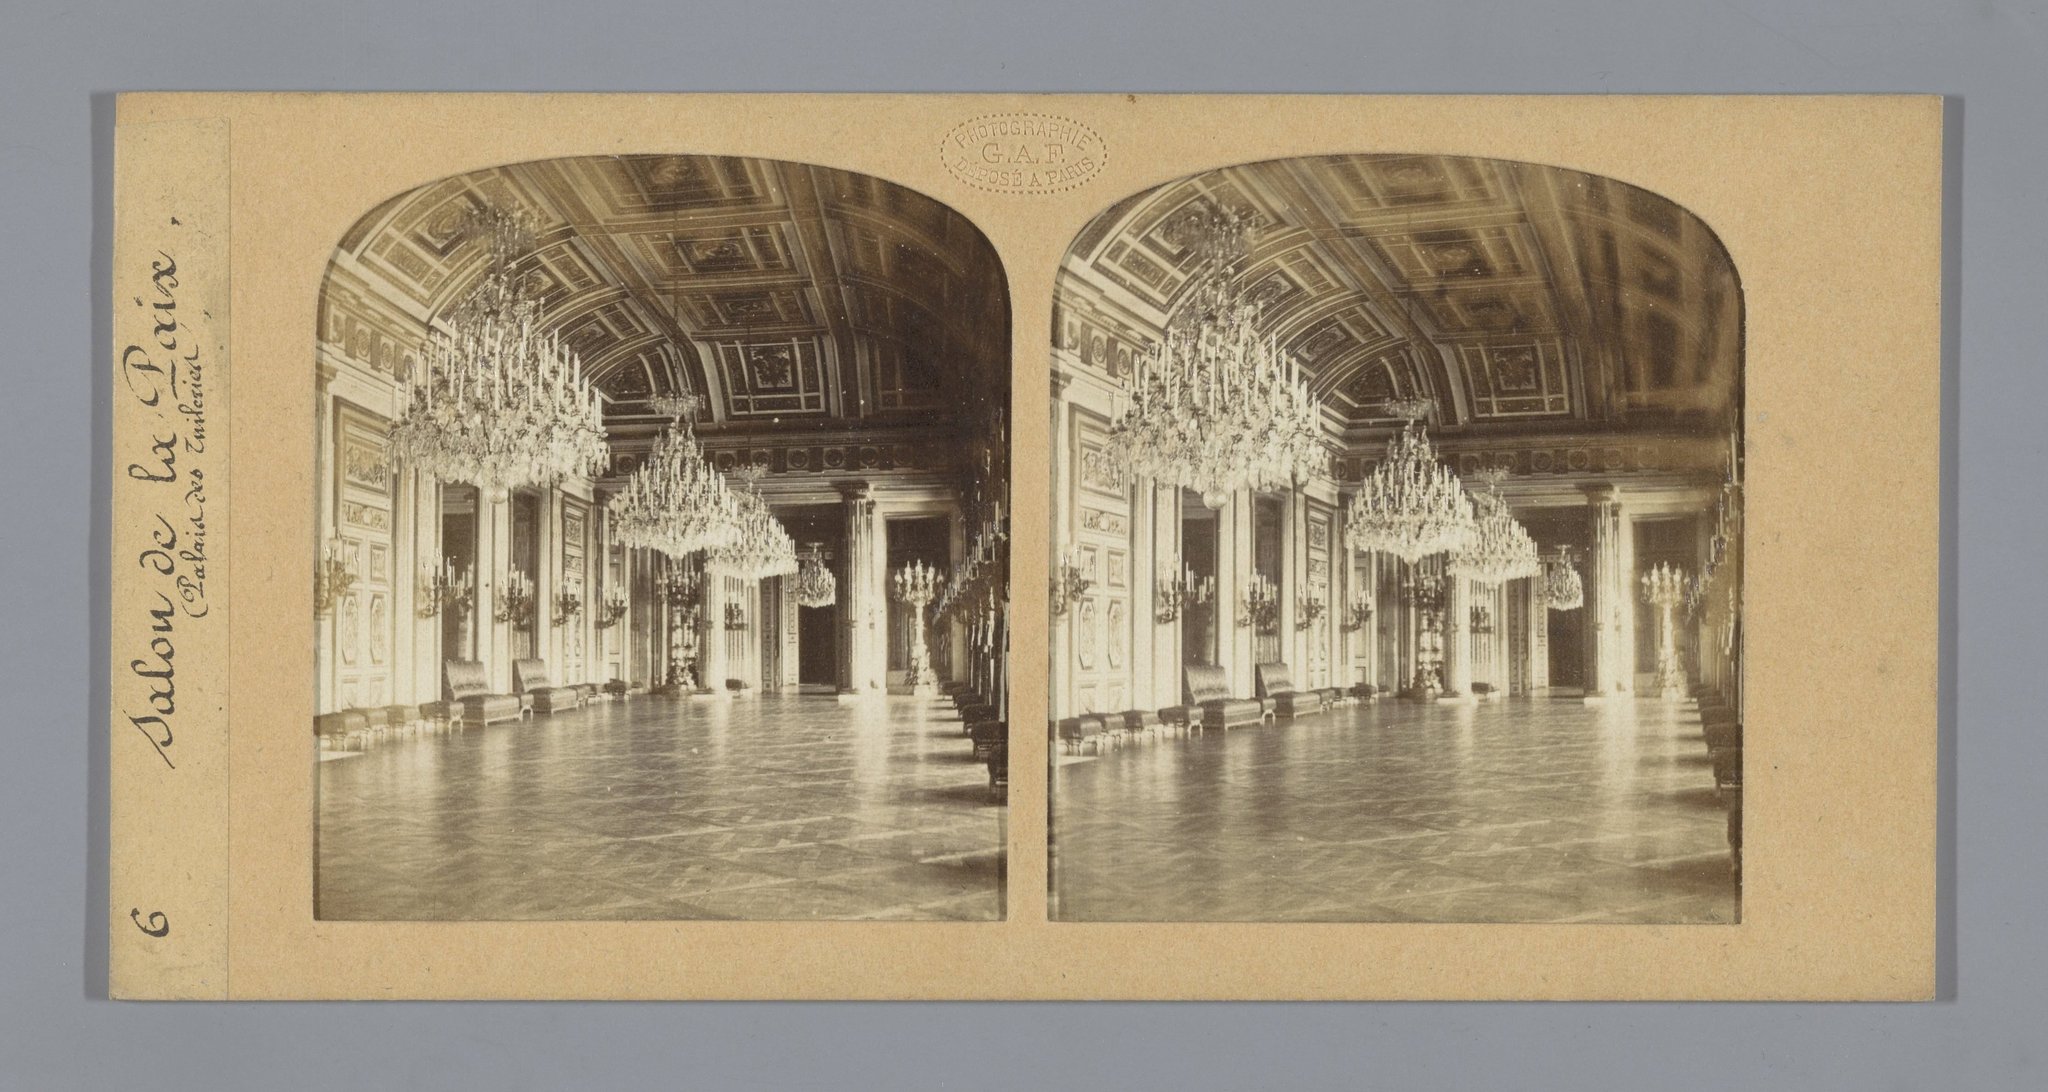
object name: tissue stereograph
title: Salon de la Paix in het Tuilerieënpaleis, Parijs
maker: florent grau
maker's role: manufacturer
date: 1858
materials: cardboard, paper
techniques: albumen print, hand coloring, perforating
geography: paris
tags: palace - aa - civic architecture: inside, tuileries palace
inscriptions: number: ‘6’, inscription: ‘Déposé a Paris’, inscription: ‘de’